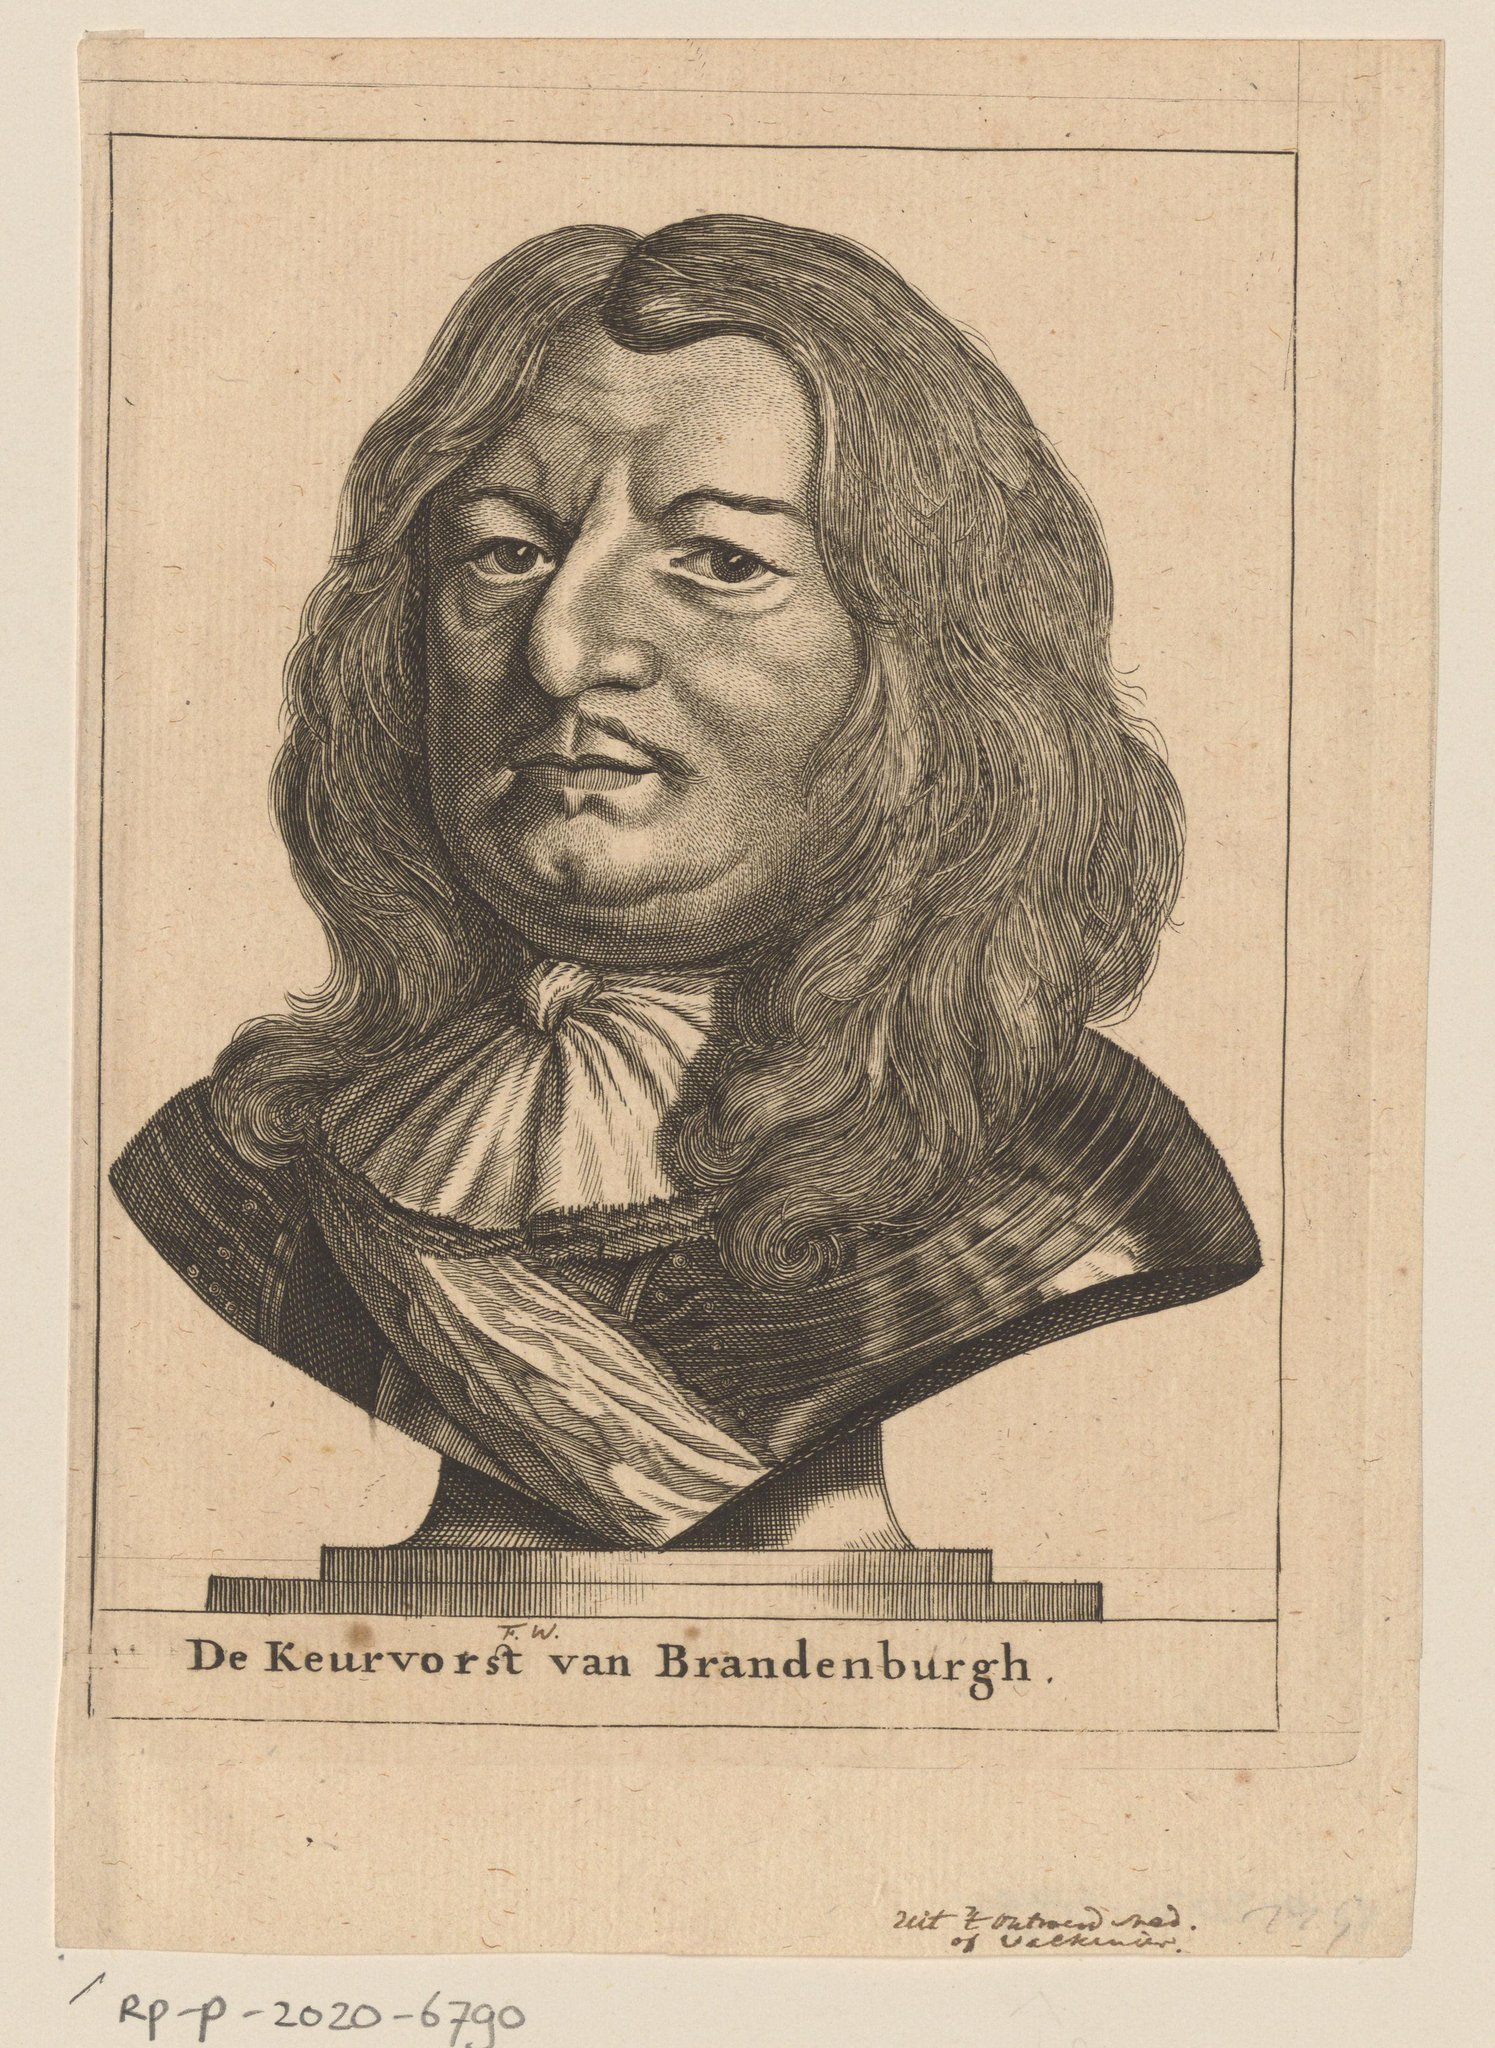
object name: print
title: Buste van Frederik Willem I van Brandenburg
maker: Anonymous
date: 1660-1750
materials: paper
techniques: engraving, etching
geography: northern netherlands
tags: berlin, frederik willem van brandenburg (i), armour, historical persons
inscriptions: inscription: ‘F.W.’, inscription: ‘uit 't ontroerd [...]ad. of Valckenier’